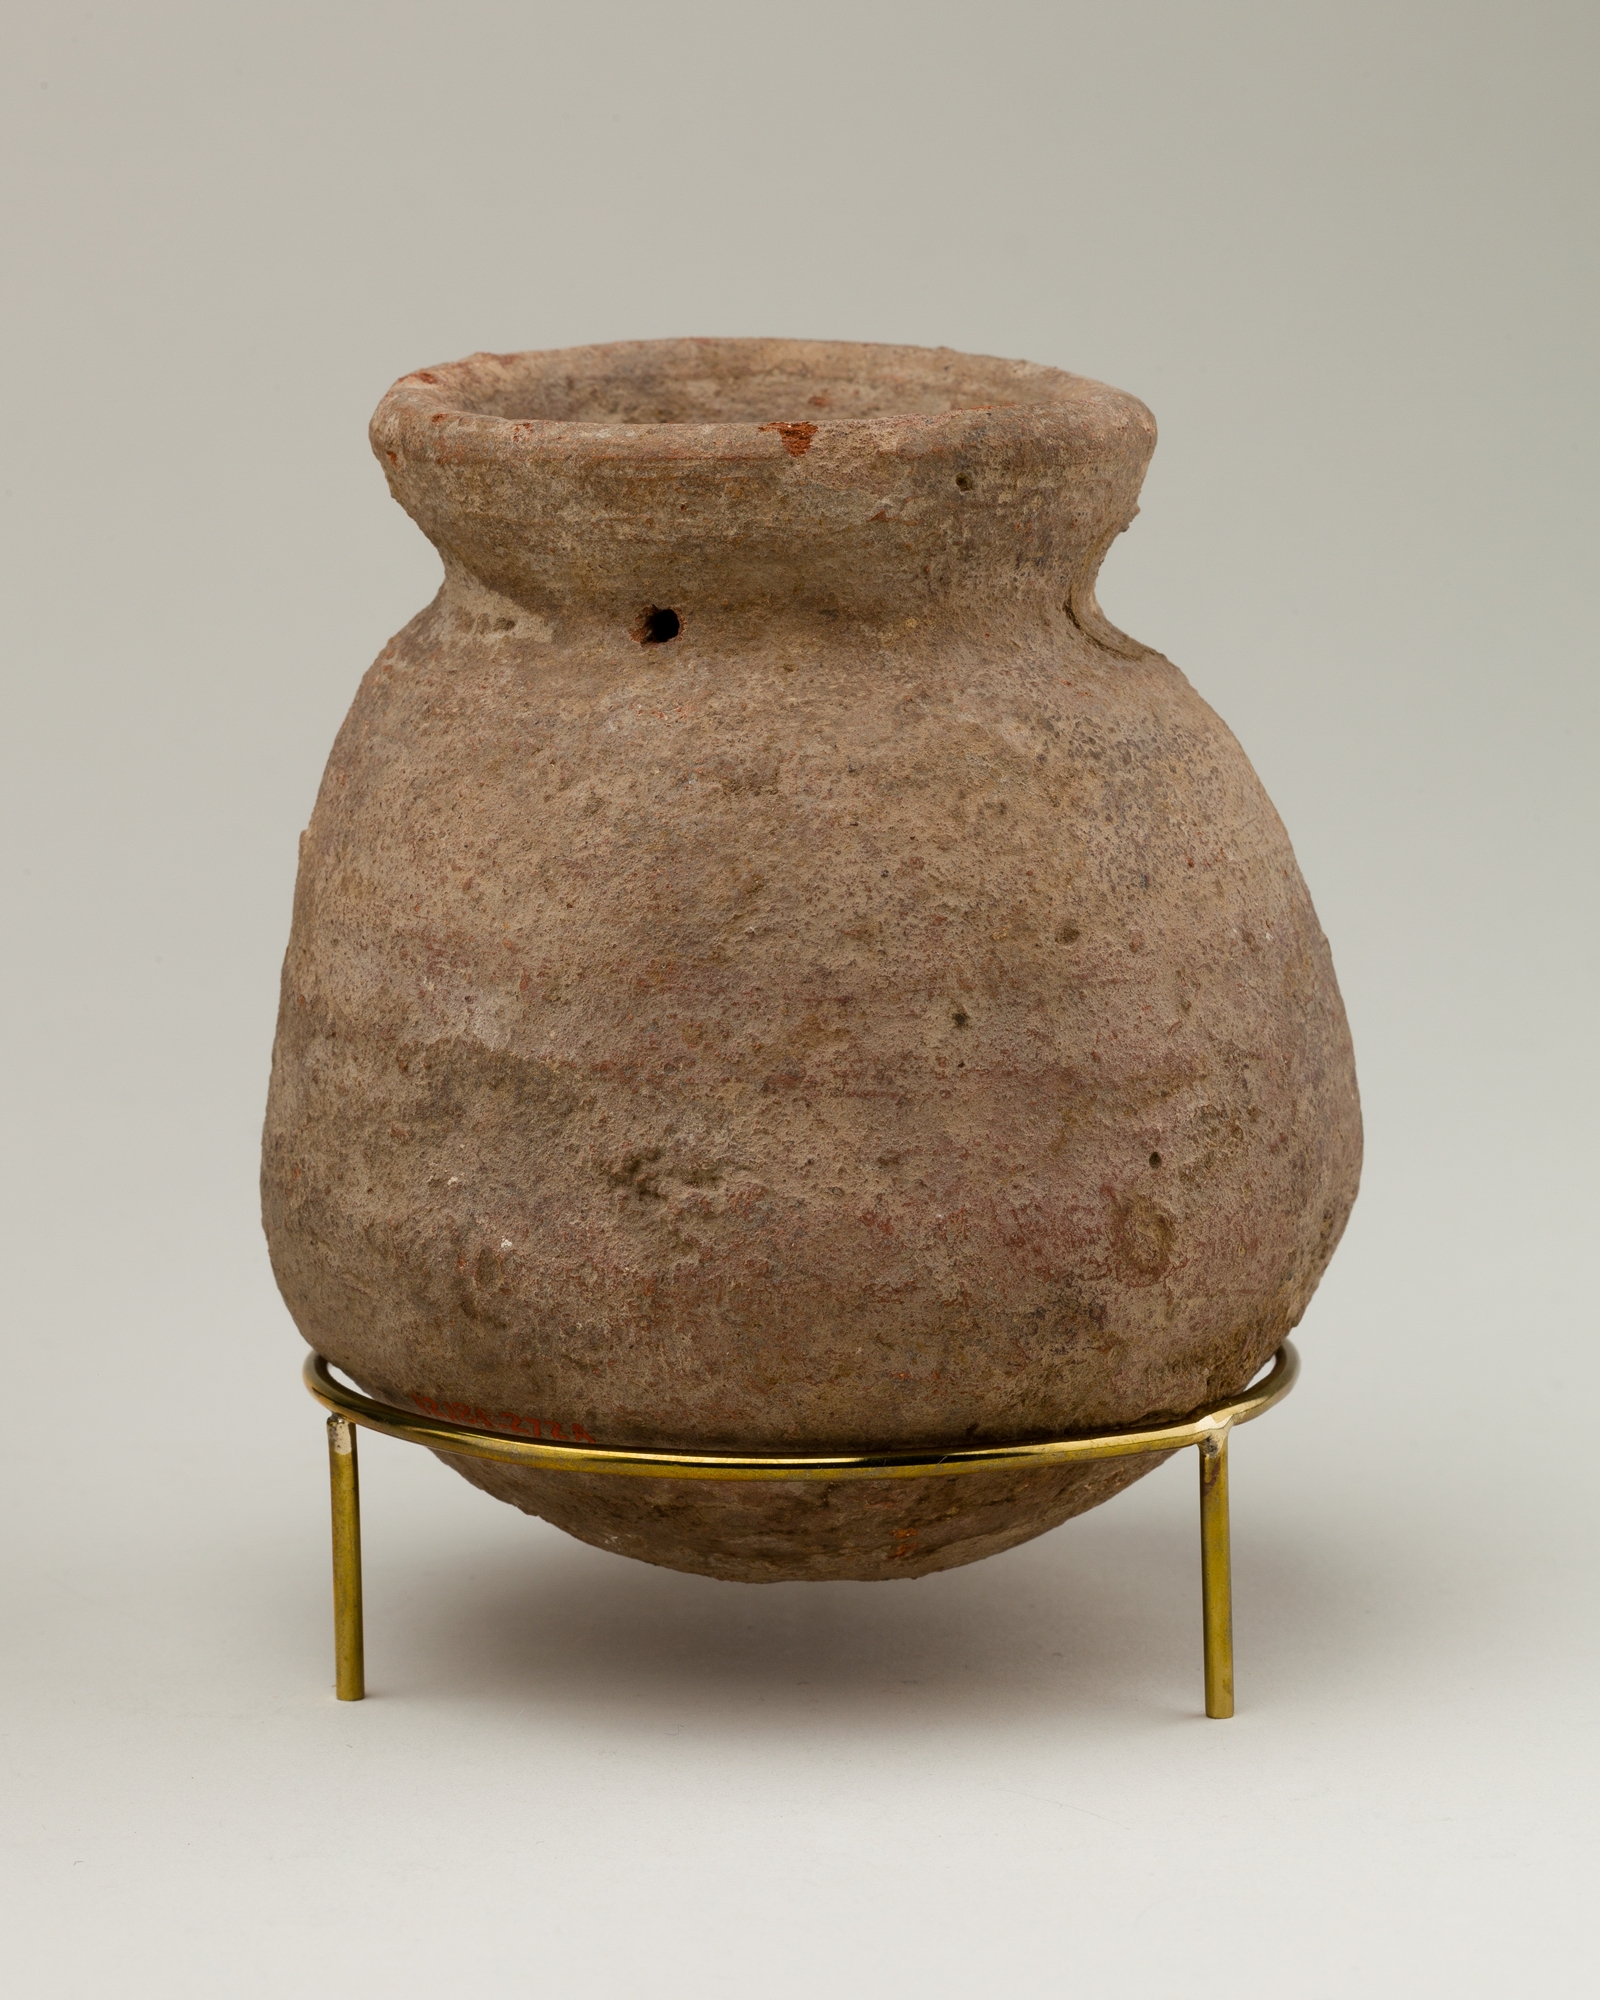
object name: pot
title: Pot That Contained a Donkey (12.181.272b-k)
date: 1991-1450 BCE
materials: pottery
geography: egypt